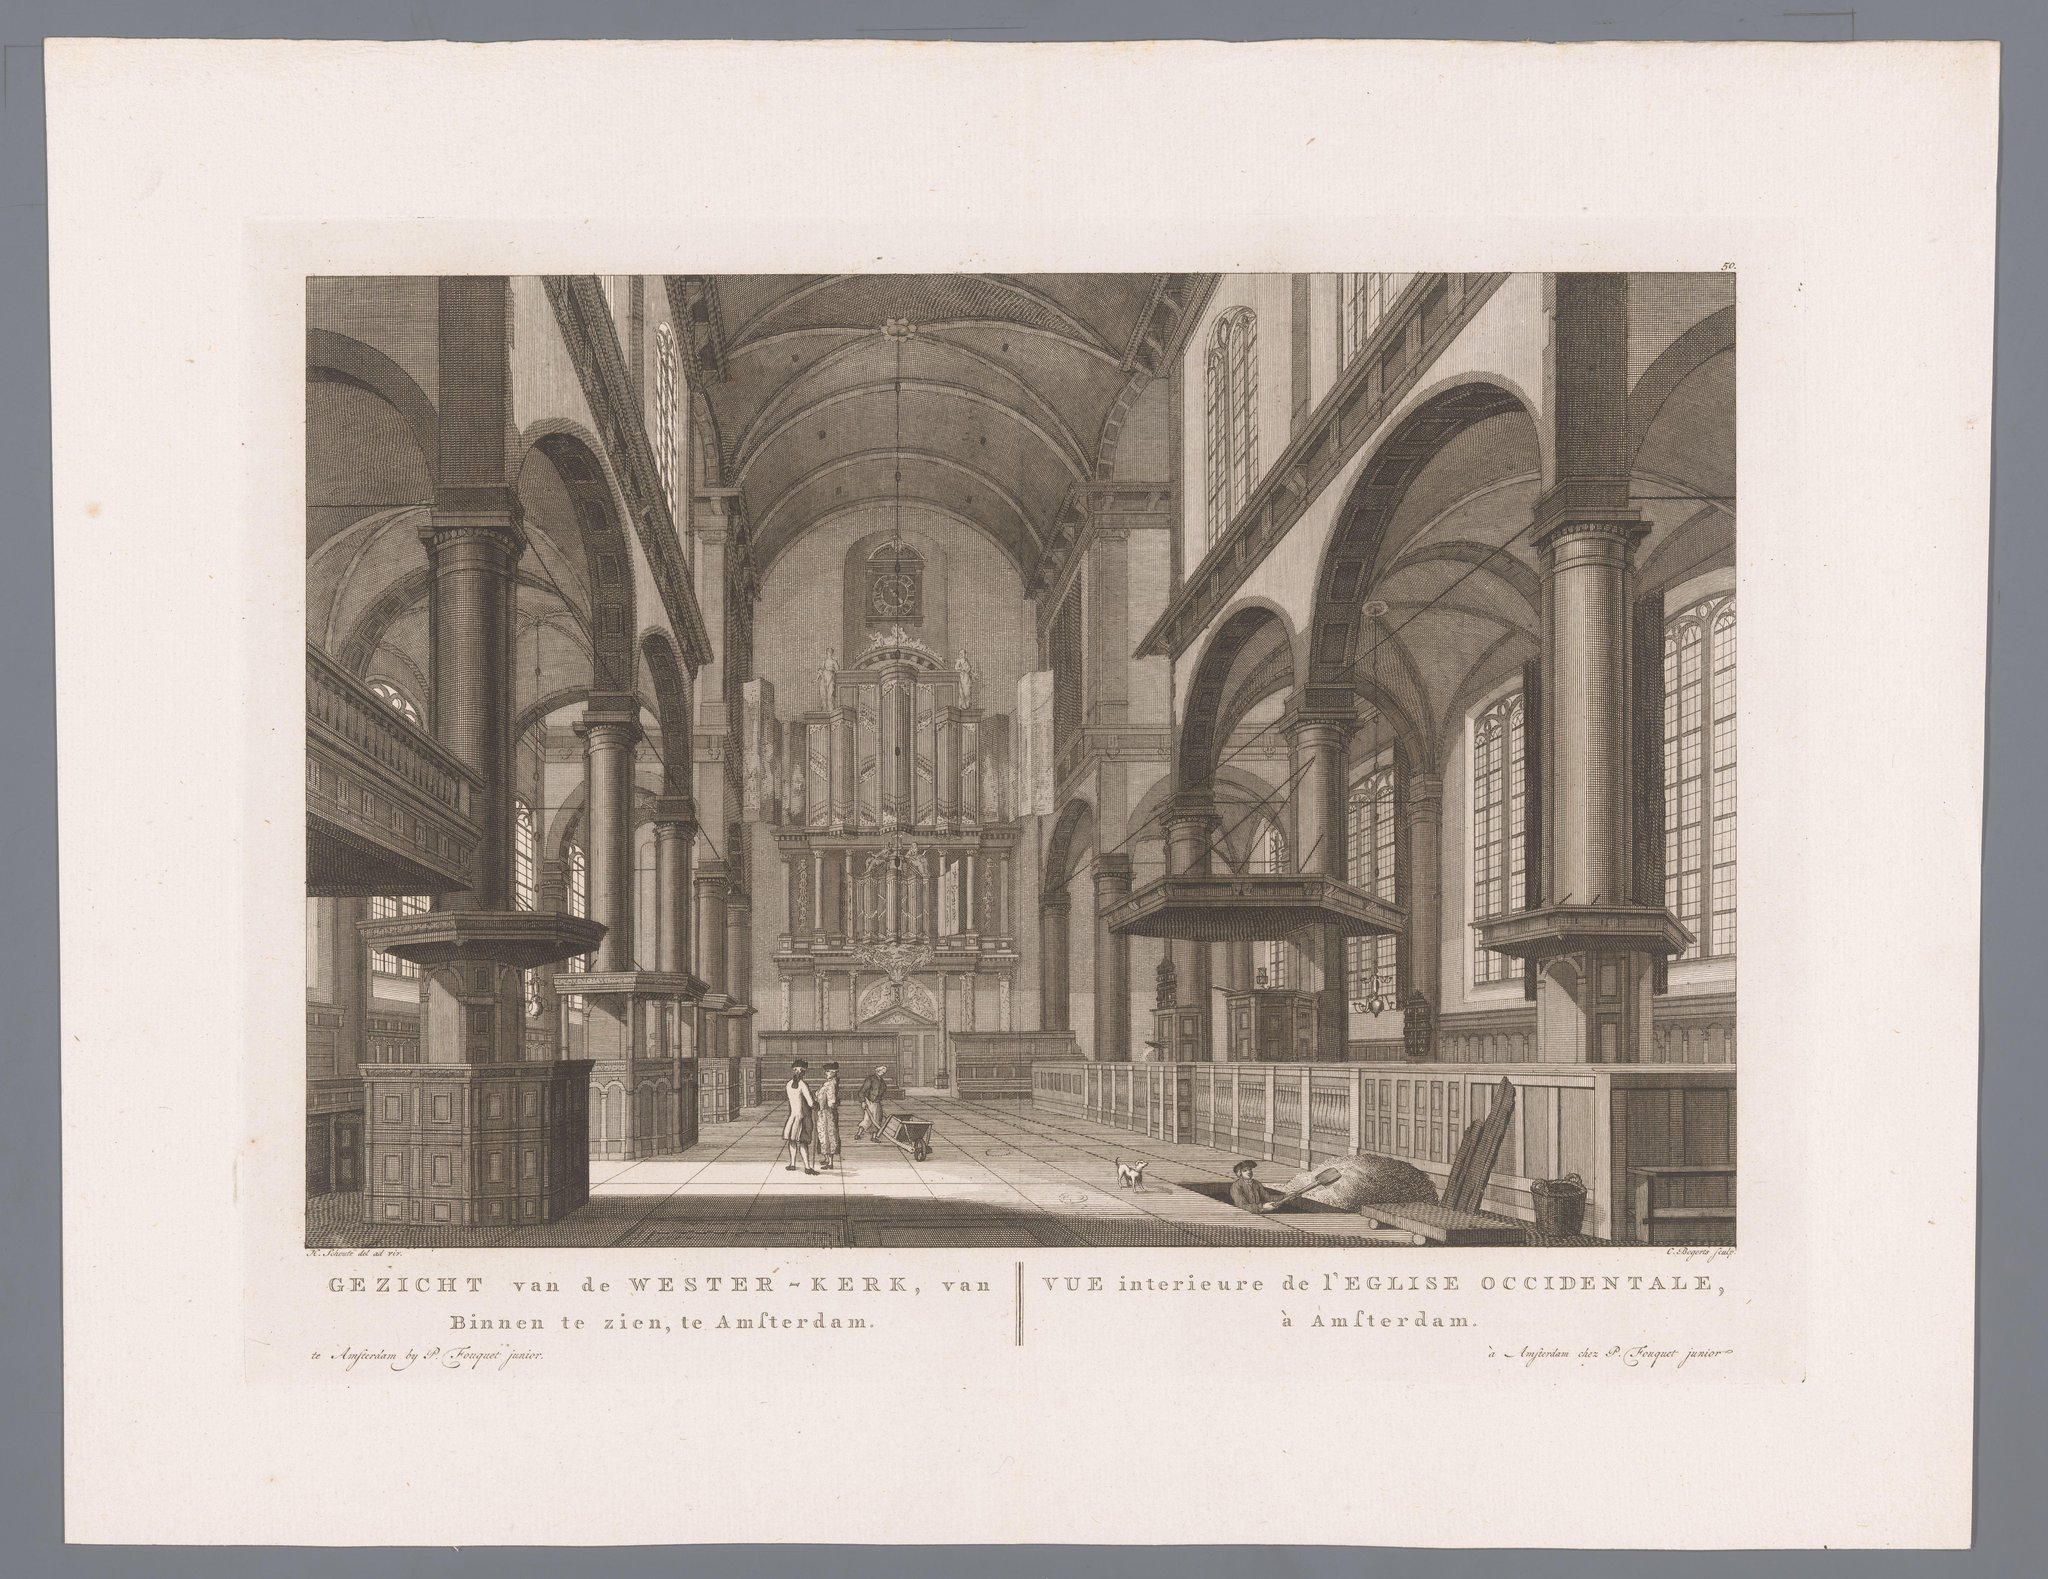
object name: print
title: Atlas van Fouquet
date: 1770-1783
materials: paper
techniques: engraving, etching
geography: amsterdam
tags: church organ, interior of church, grave digger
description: Vanaf 1760 gaf Pierre Fouquet stadsgezichten van Amsterdam naar tekeningen van verschillende kunstenaars uit. Deze prenten werden aanvankelijk los verkocht. Later werden ze samengebonden verkocht in verschillende volgordes en aantallen in: (1). Afbeeldingen van de wyd-vermaarde koopstad Amsterdam benevens des zelvs voornaamste gebouwen en gezigten alle naar het leeven getekend / Receuil des edifices les plus considerables et des plus belles vues, de la fameuse ville d'Amsterdam, dessinées d'après nature. Amsterdam: Pierre Fouquet, 1778-1783. Deze 'uitgave' bestond waarschijnlijk alleen uit een titelblad en inhoudsopgave van de tot dusver 100 uitgegeven prenten, die de koper zelf aan zijn of haar reeds verzamelde prenten kon toevoegen. De hoeveelheid en volgorde van prenten verzameld onder deze titel verschilt dus sterk. (2). Nieuwe atlas, van de voornaamste gebouwen en gezigten der stad Amsterdam, met derzelver beknopte beschryvingen. 2 dln. Amsterdam: Daniël Jean Changuion en Petrus den Hengst [in opdracht van Pierre Fouquet], 1783. Ook werden er door verschillende uitgevers tussen 1788 (Amsterdam: Petrus Conradi) en 1805 (Amsterdam: Evert Maaskamp) heruitgaven gepubliceerd.